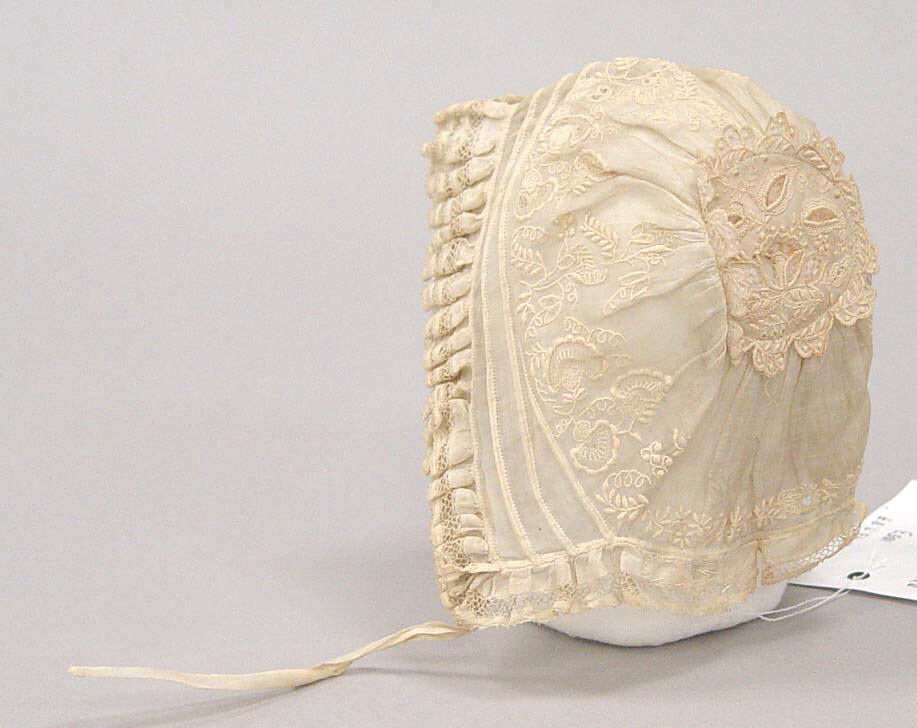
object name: bonnet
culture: american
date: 1853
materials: cotton